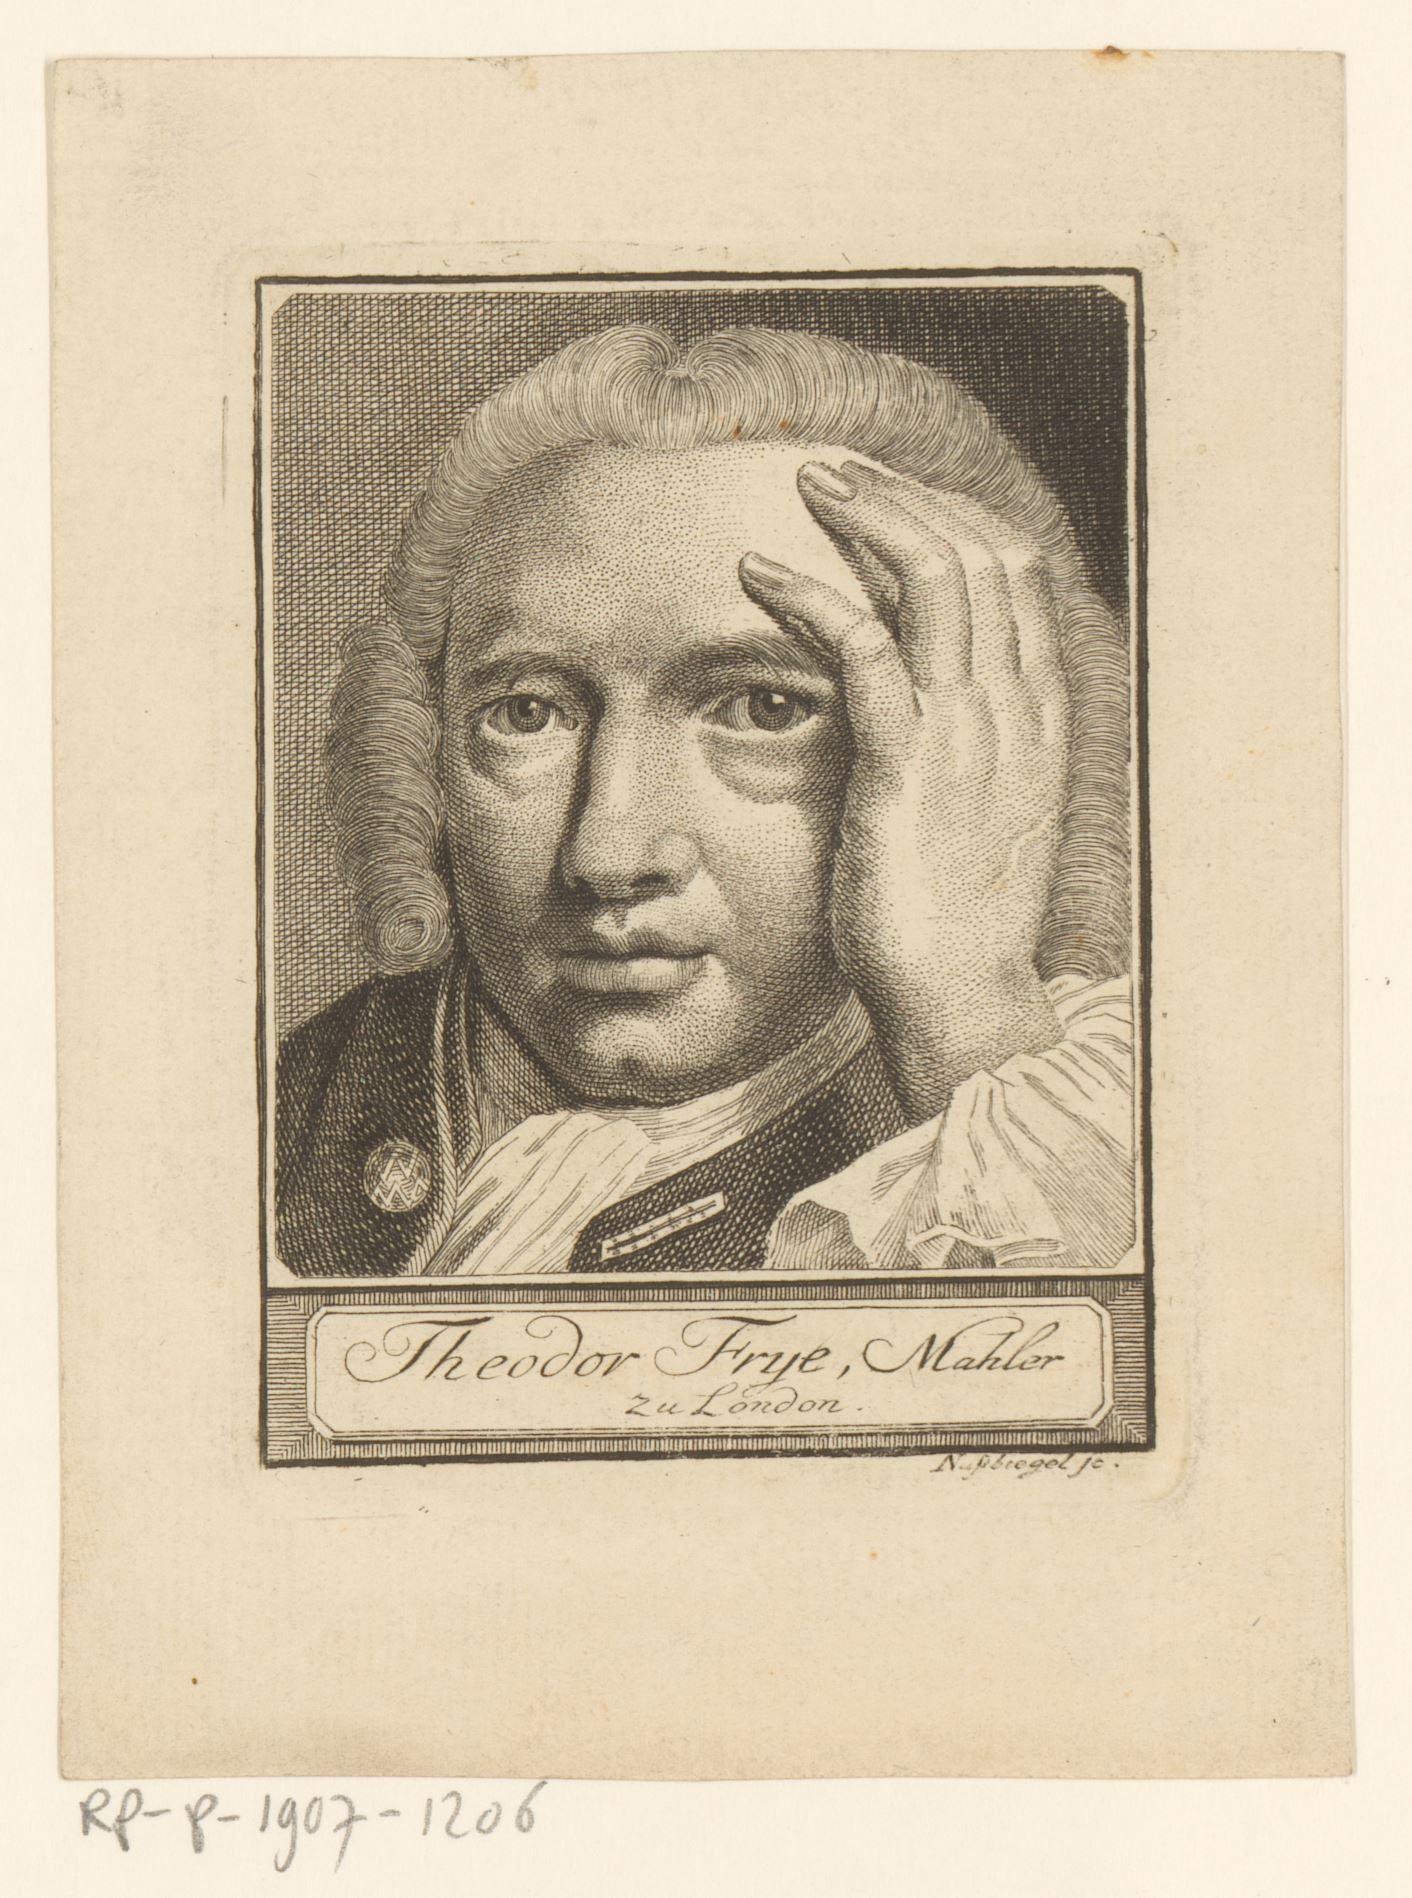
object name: print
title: Portret van Thomas Frye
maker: johann nusbiegel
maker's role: print maker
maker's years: 1750-1829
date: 1760-1829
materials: paper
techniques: engraving, etching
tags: london, thomas frye, historical persons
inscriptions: collector's mark: Lugt 2228